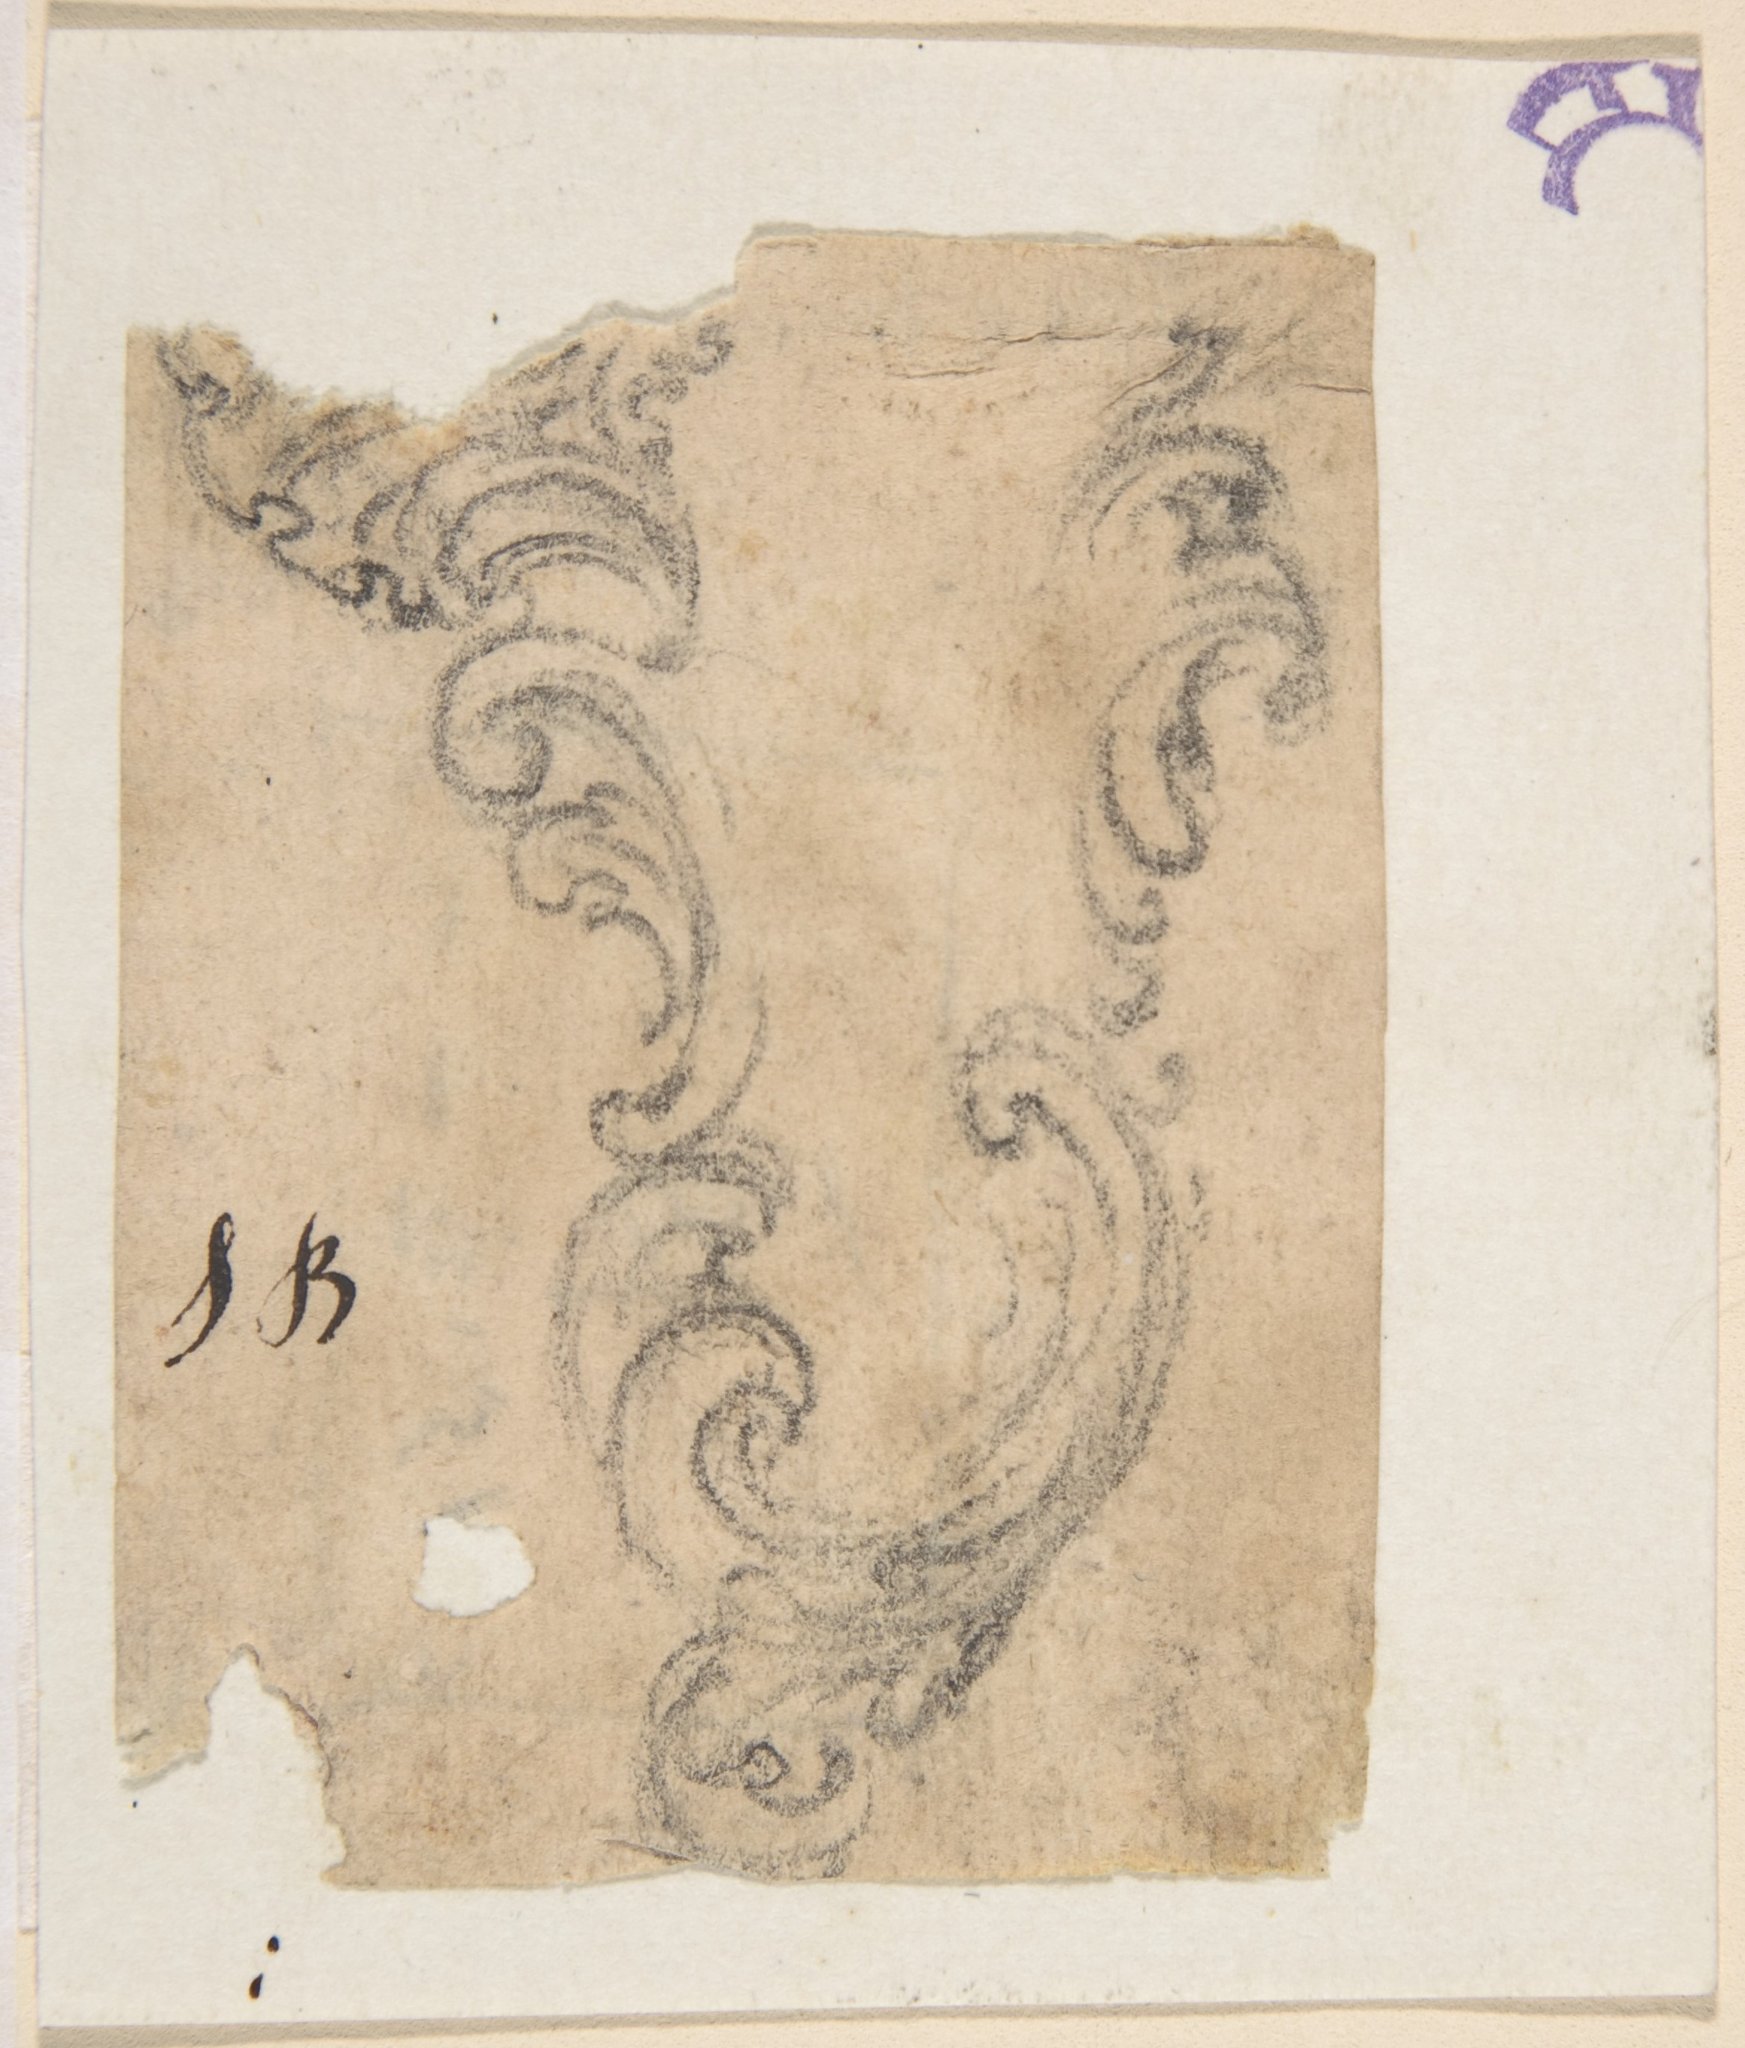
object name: drawing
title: Design for a Rocaille Cartouche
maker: giovanni battista foggini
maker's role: artist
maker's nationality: italian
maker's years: 1652-1725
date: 1672-1725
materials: chalk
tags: cartouches